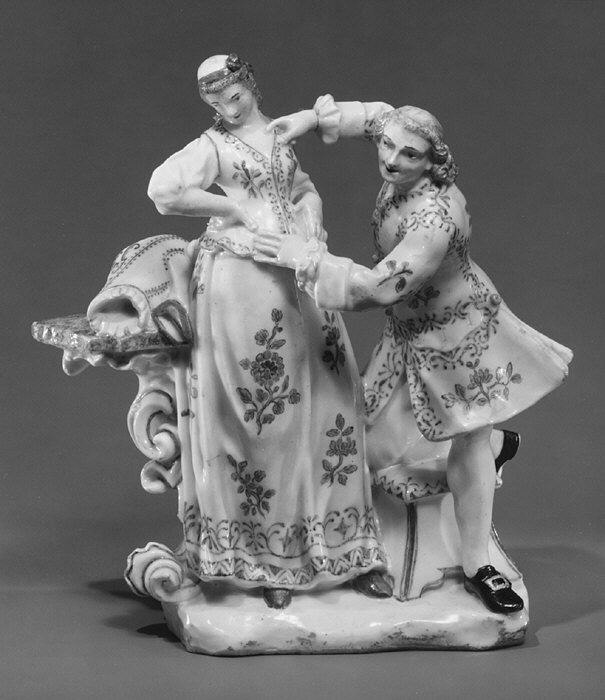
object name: group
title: Woman and her tailor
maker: capodimonte porcelain manufactory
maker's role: manufactory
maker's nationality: italian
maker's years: 1740-1759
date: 1744-1746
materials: soft paste porcelain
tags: men,women,flowers